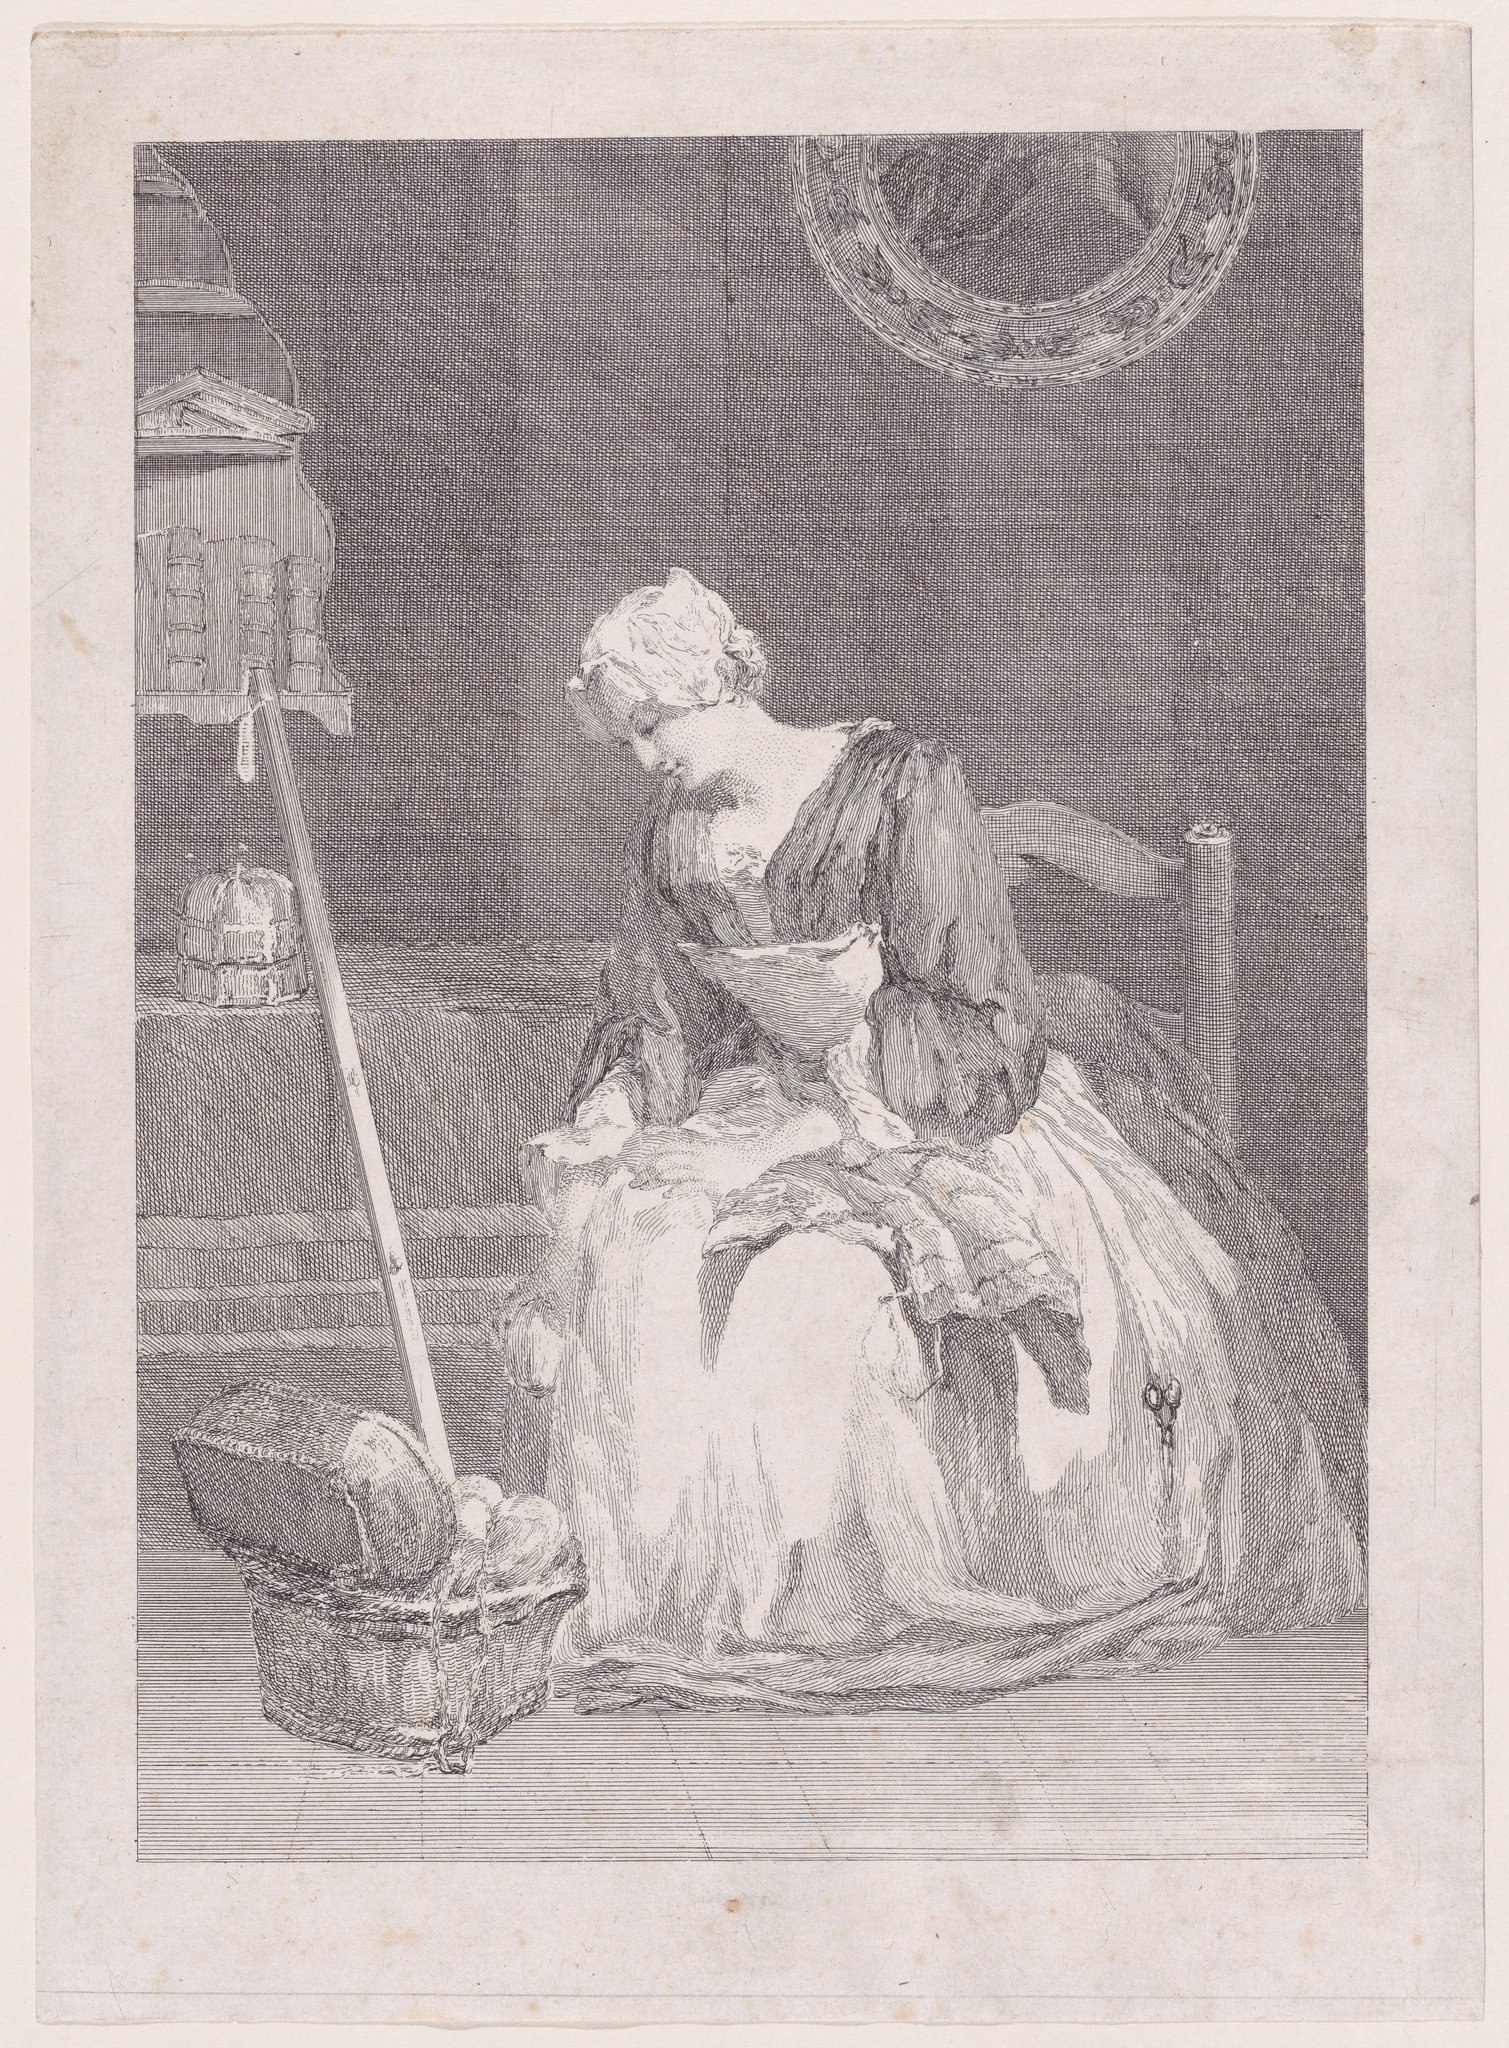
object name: print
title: The Embroiderer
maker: jean jacques flipart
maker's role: artist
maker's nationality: french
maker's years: 1719-1782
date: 1757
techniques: etching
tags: women,needlework